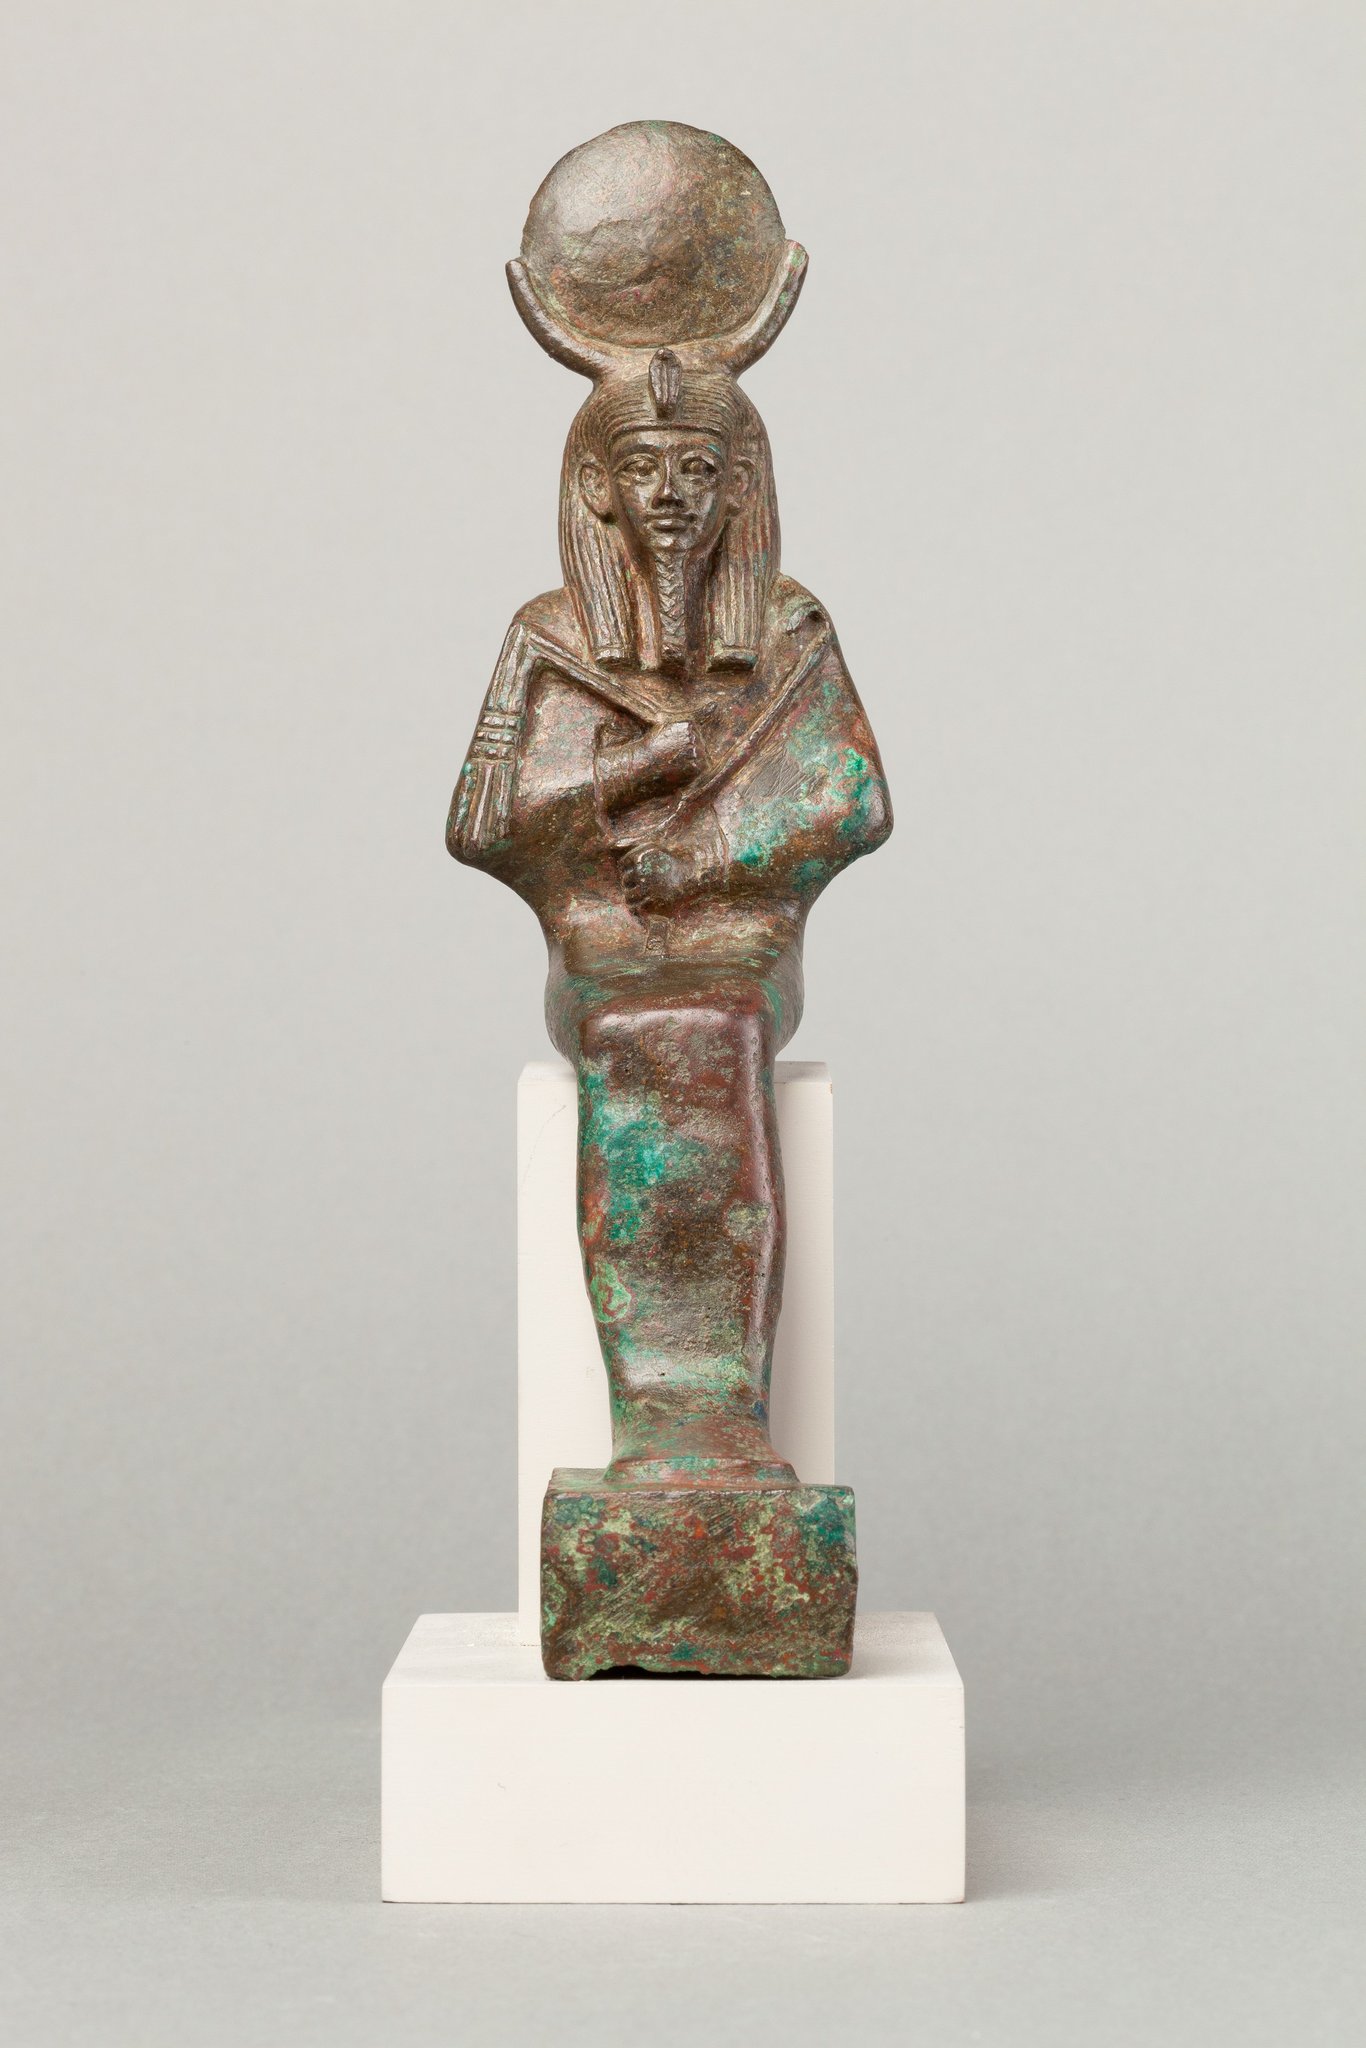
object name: statuette, osiris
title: Osiris-Iah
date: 664-332 BCE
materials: metal, metal leaf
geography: egypt